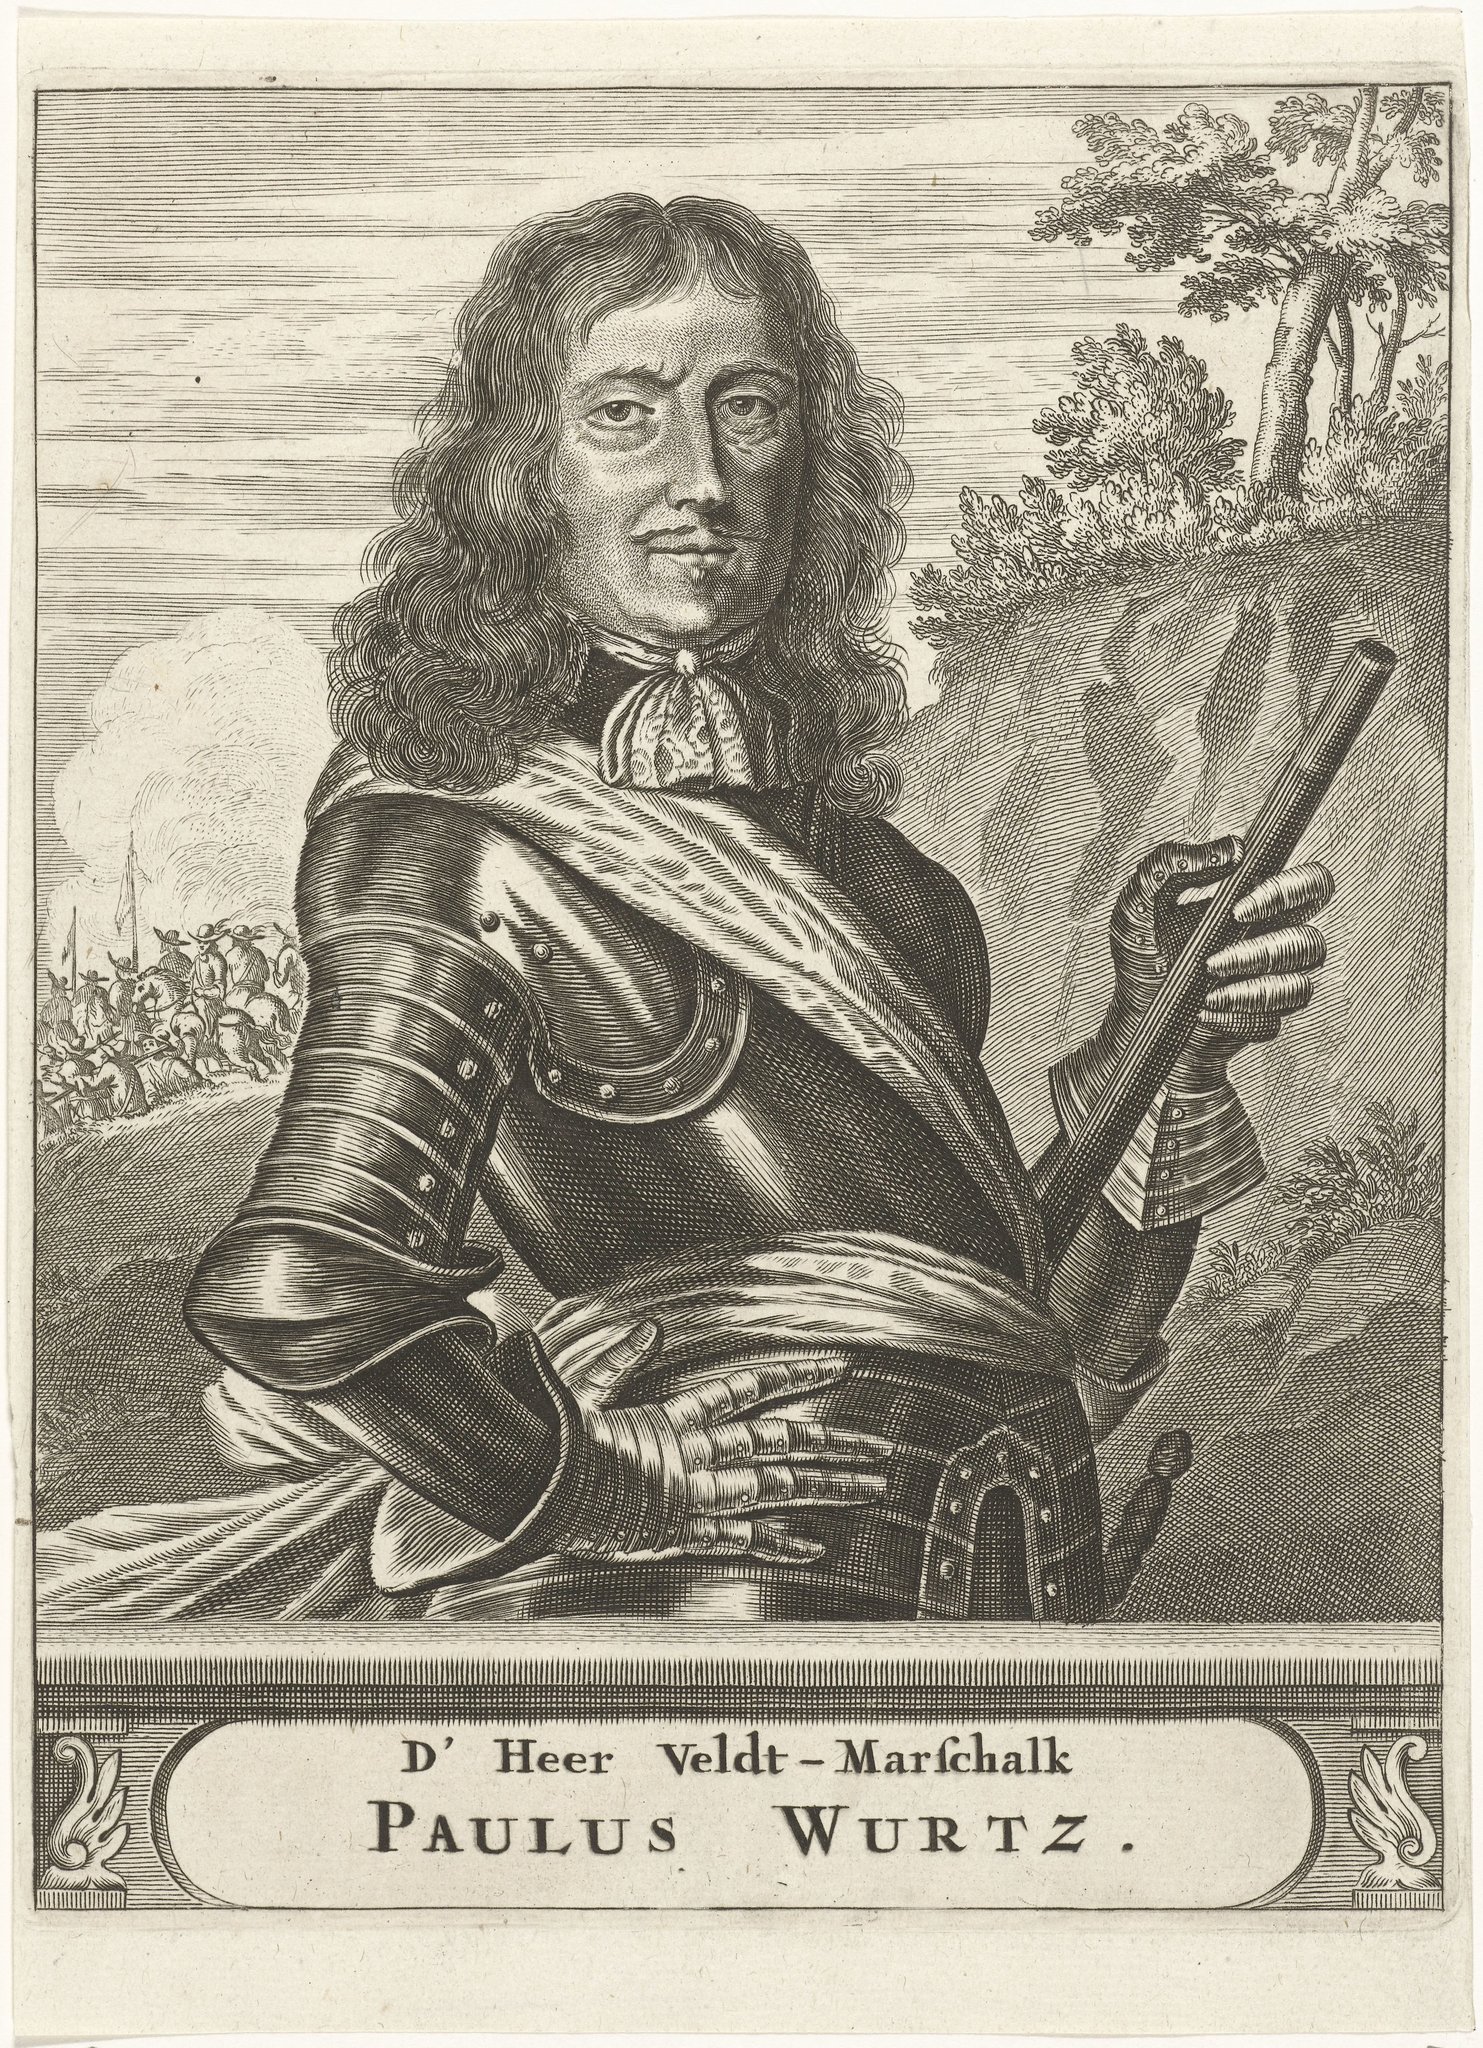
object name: print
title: Portret van Paul Wurz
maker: christiaan hagen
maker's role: draughtsman, print maker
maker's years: 1635-1707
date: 1663-1695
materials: paper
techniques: engraving, etching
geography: amsterdam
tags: belt, girdle, waistband, armour, battle, shoulder-belt, bandoleer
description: Portret ten halven lijve naar rechts van Paul Wurz, gekleed in een harnas. In zijn linkerhand houdt hij een commandostaf. Op de achtergrond is een veldslag afgebeeld. Onder zijn portret een plint, waarop zijn naam en titel in twee regels in een cartouche.